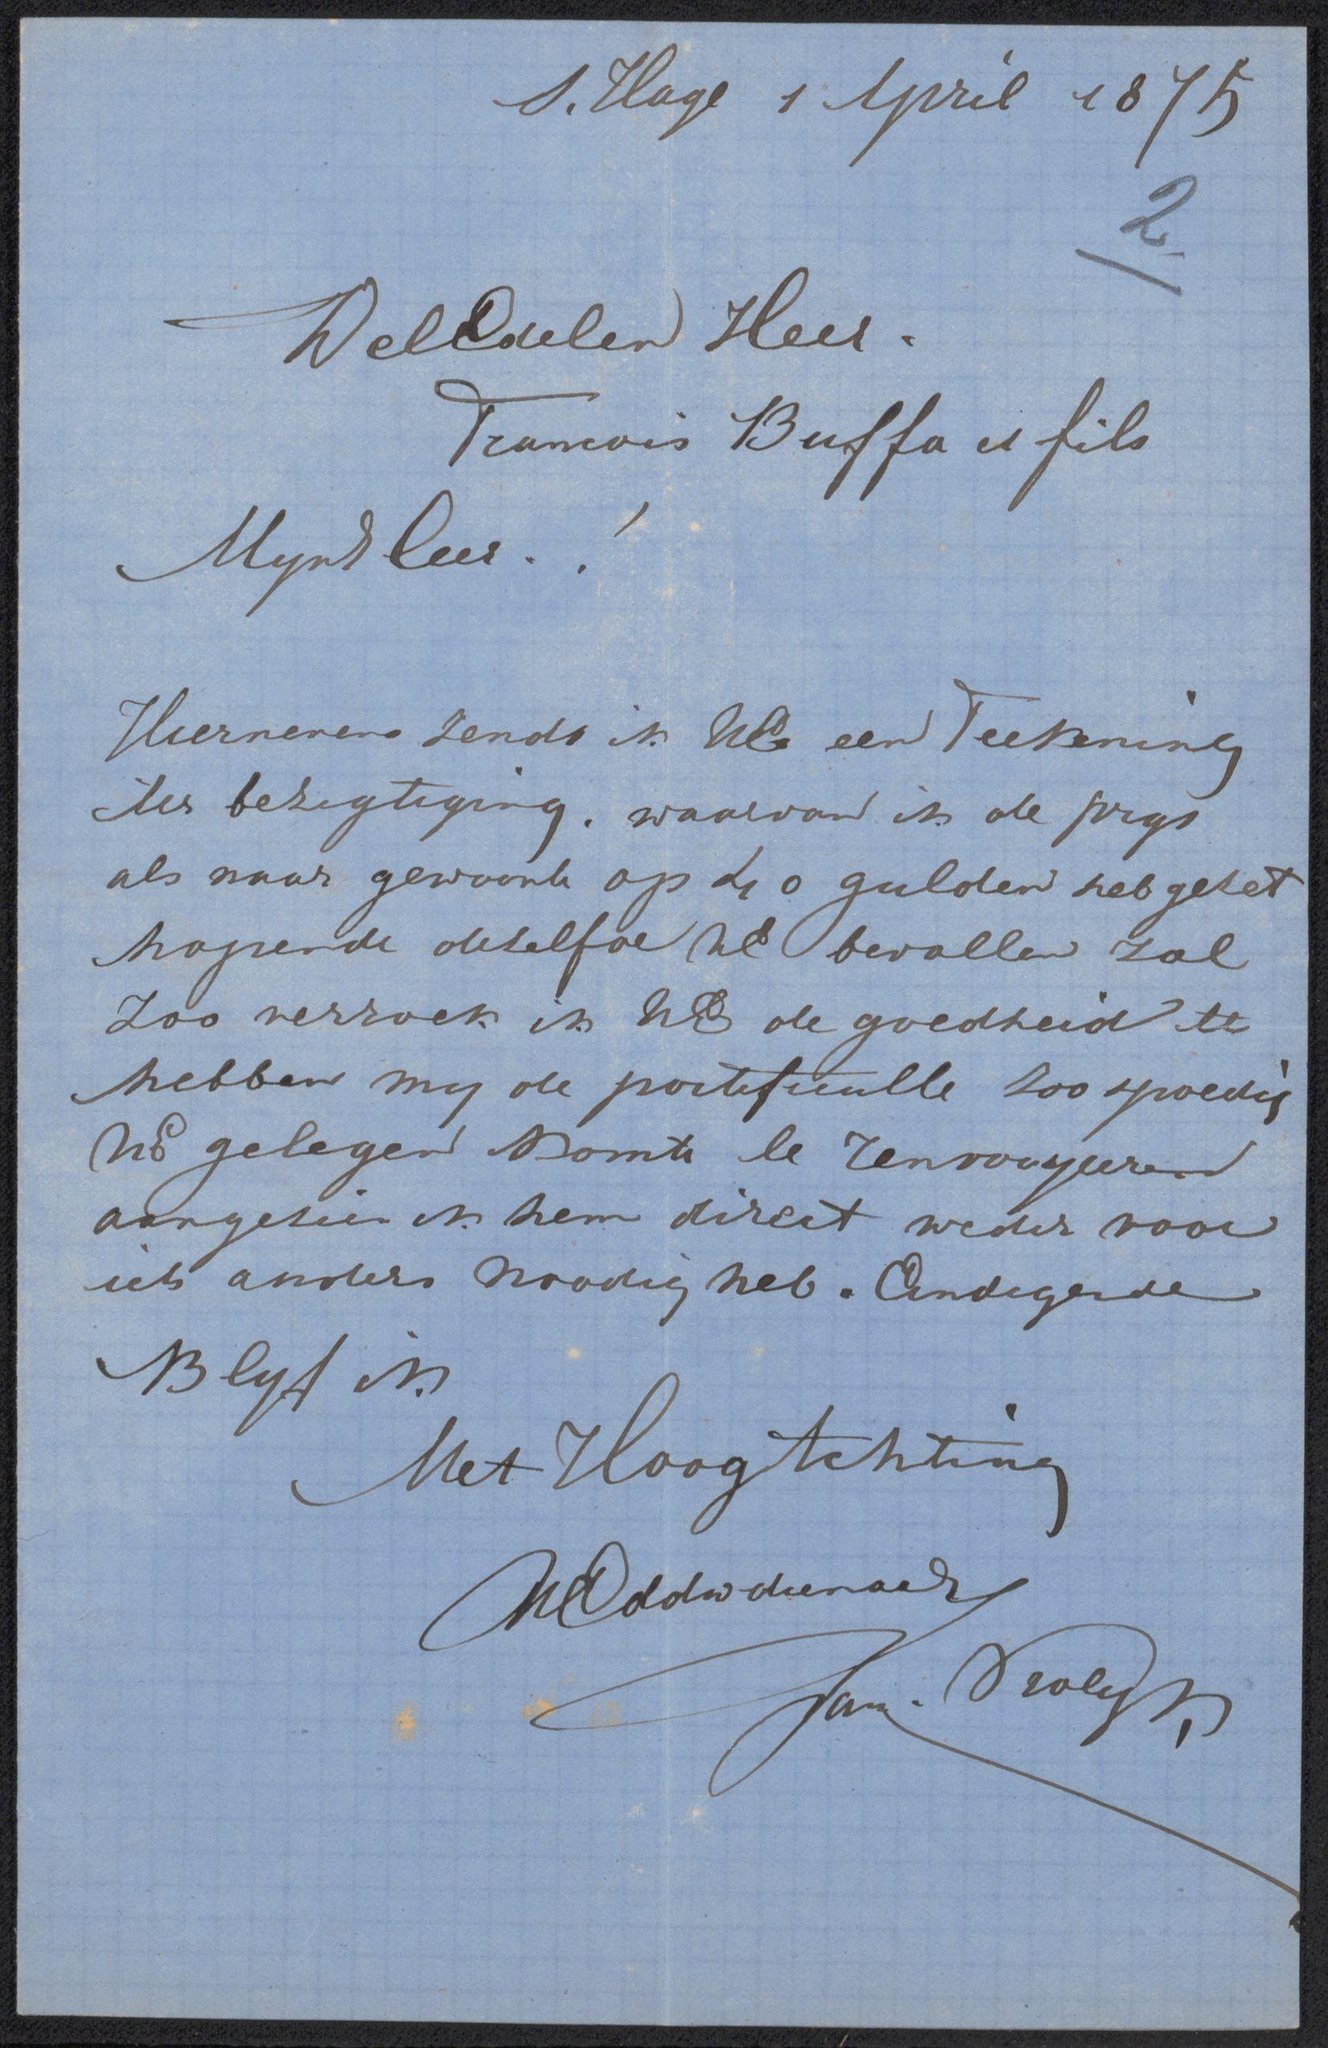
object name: letter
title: Brief aan Frans Buffa en Zonen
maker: jan vrolijk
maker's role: draughtsman, painter, print maker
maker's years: 1846-1894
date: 1875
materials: ink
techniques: pen, writing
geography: the hague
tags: publisher, art trade, art shop, drawing, money